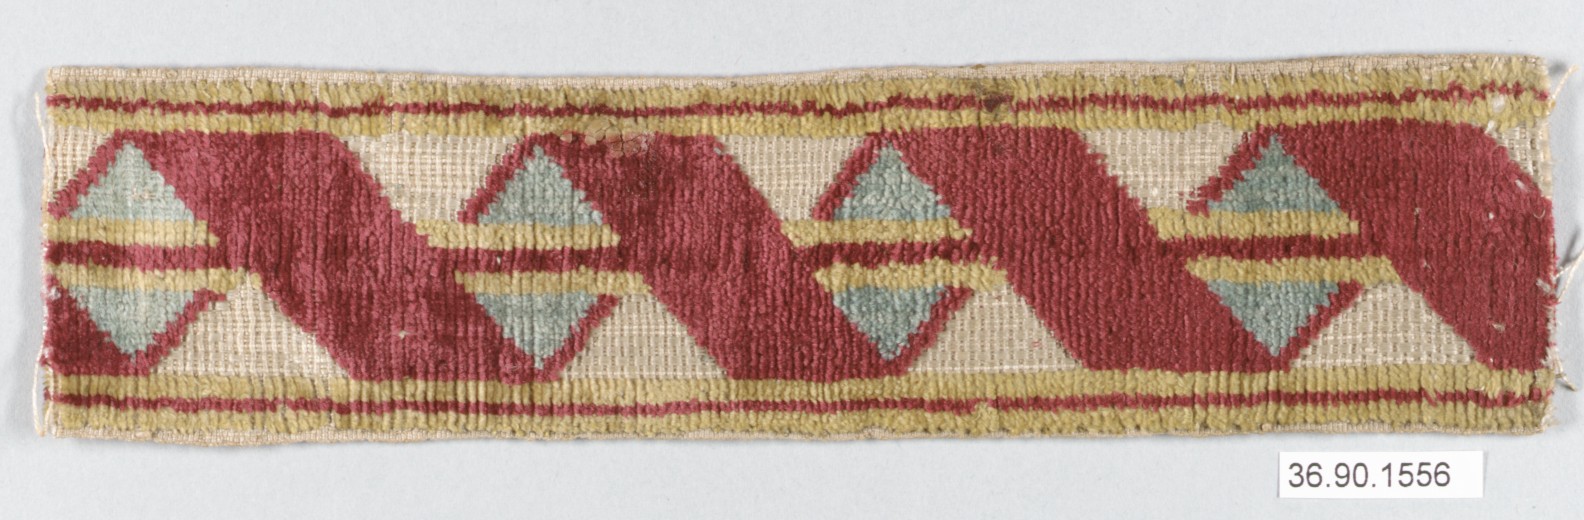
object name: galloon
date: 1701-1900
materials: silk